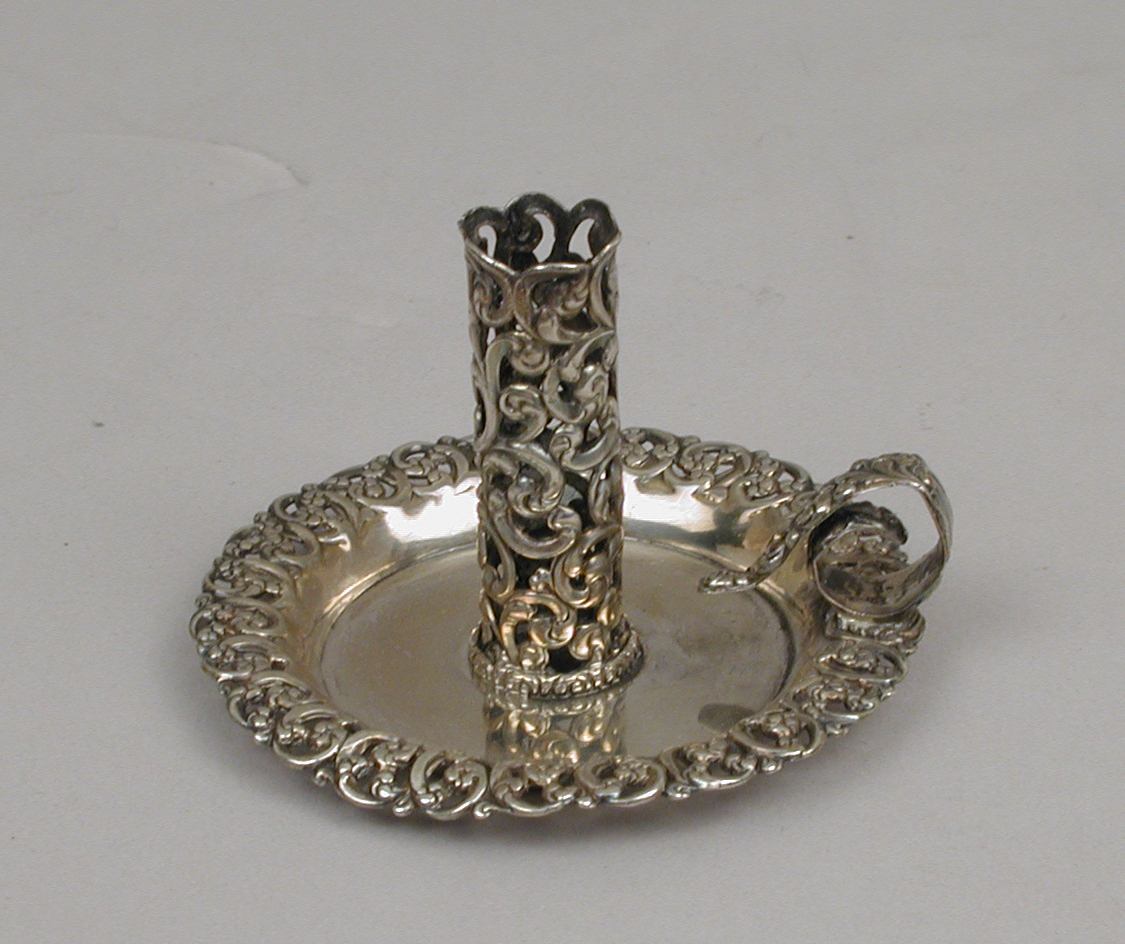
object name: taperstick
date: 1890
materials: silver